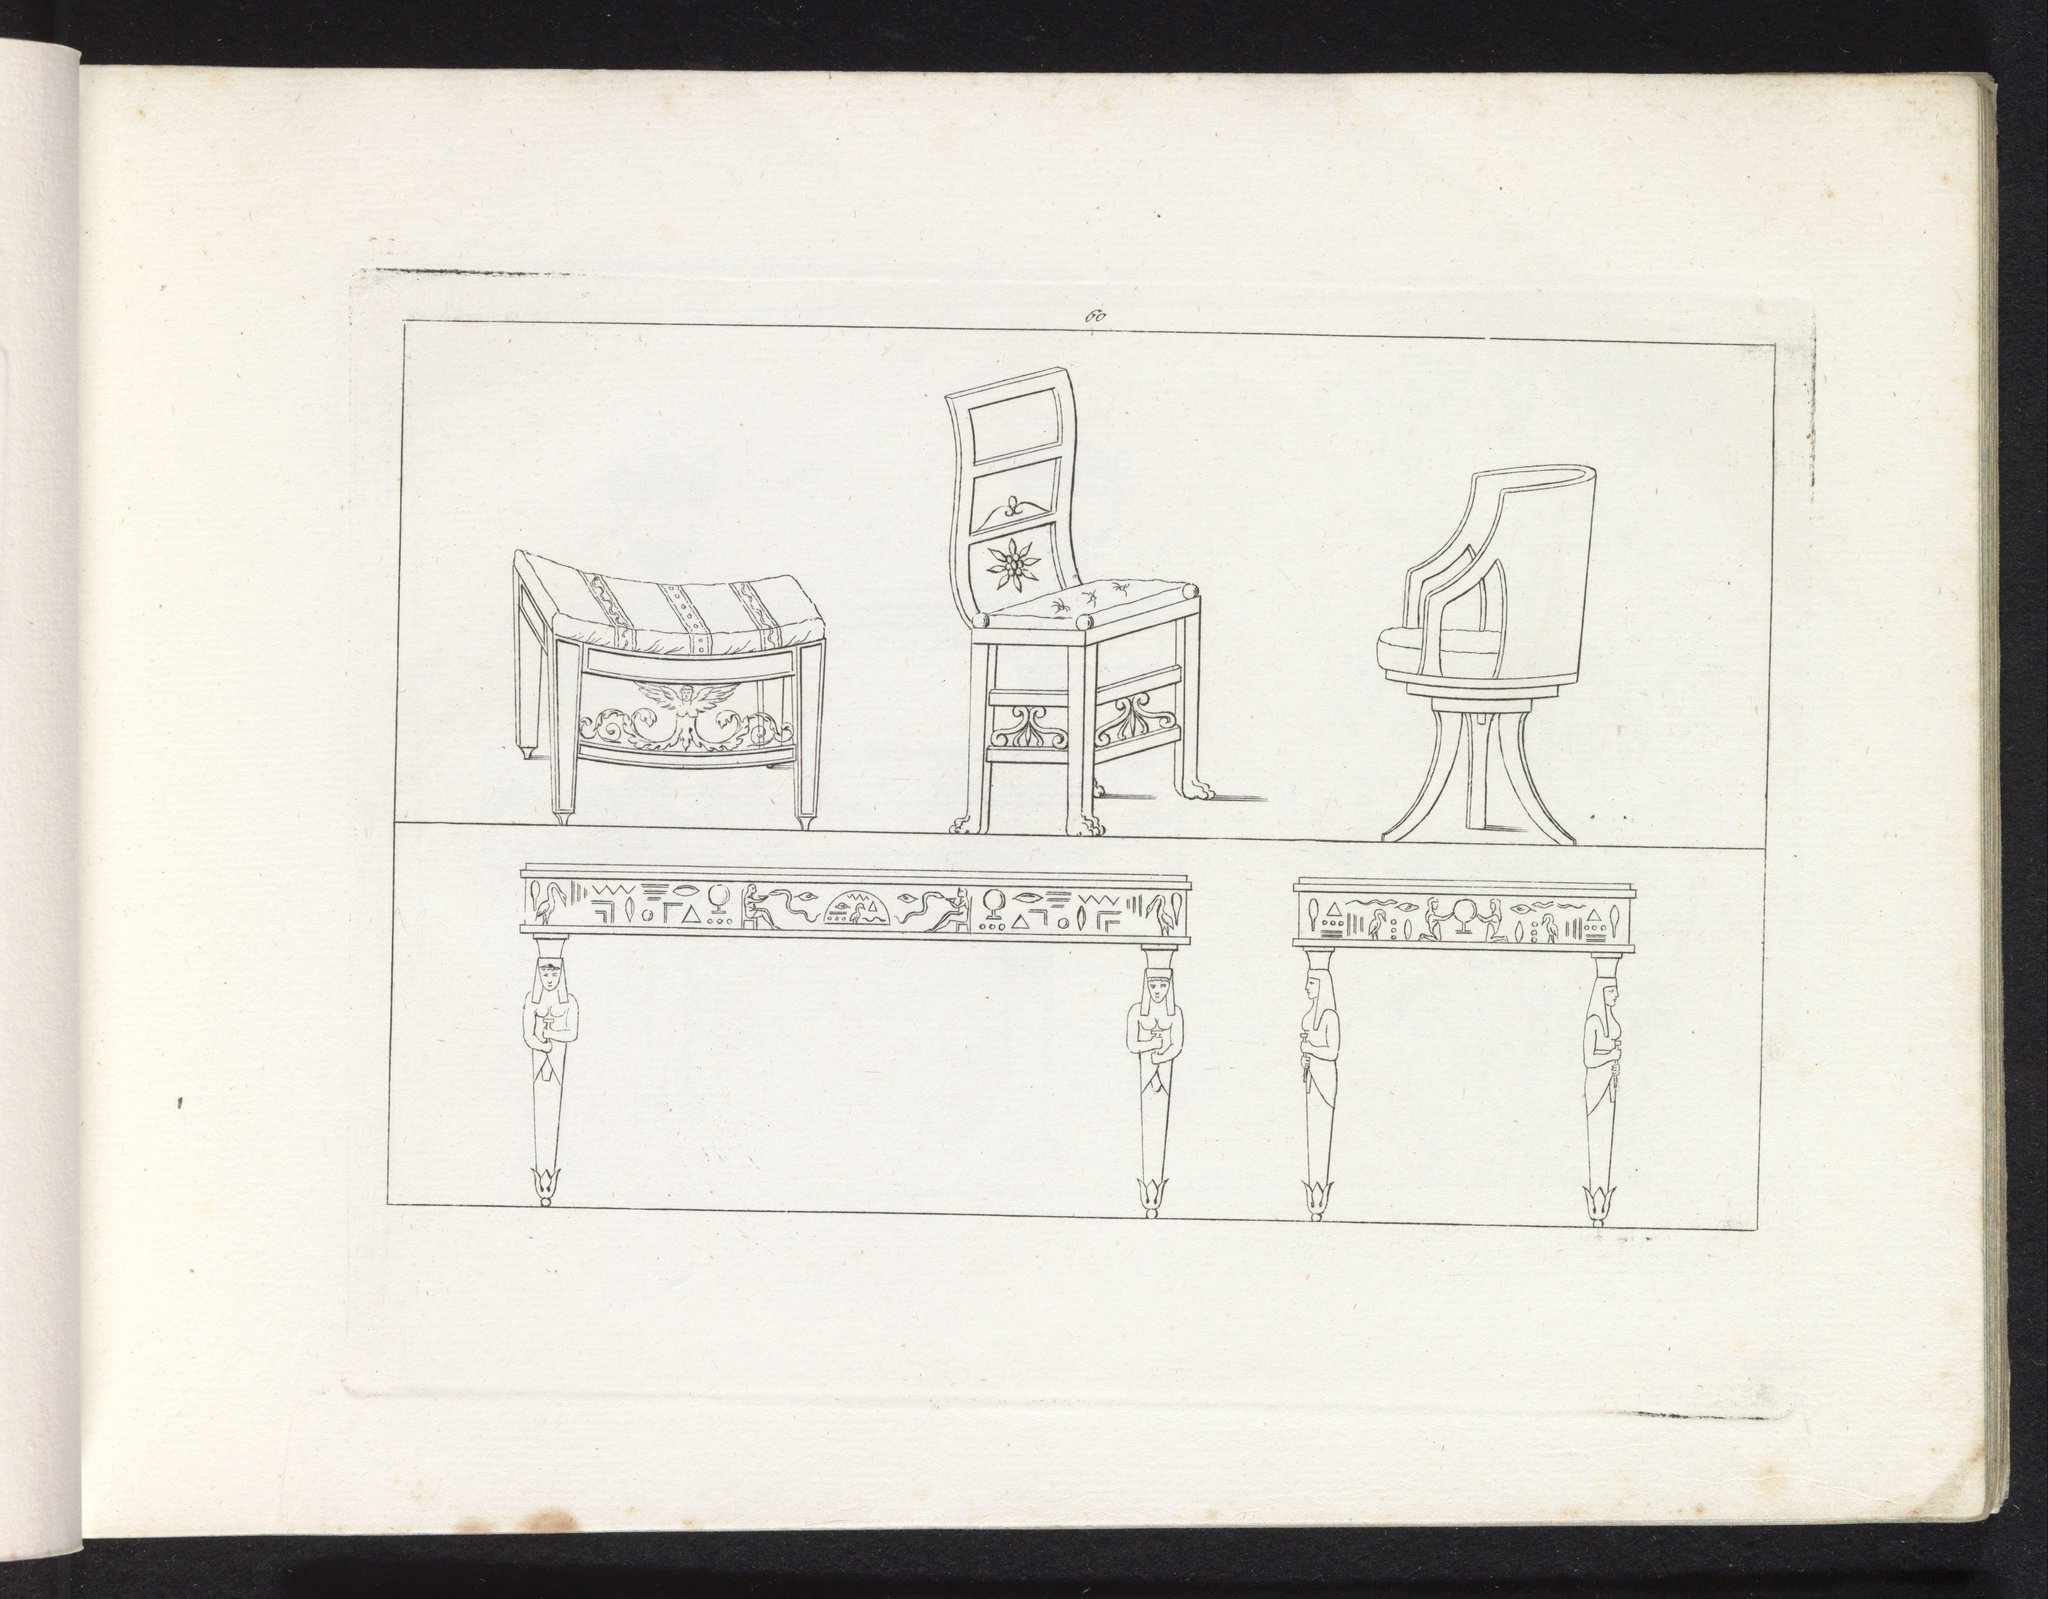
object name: album leaf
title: Ontwerpen voor religieuze en profane voorwerpen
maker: pietro ruga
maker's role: print maker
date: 1817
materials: paper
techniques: etching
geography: italy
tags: bench, ornaments ~ art, table, chair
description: Prent maakt deel uit van een reeks van 100 prenten (+ titelprent) met ontwerpen voor religieuze en profane voorwerpen.